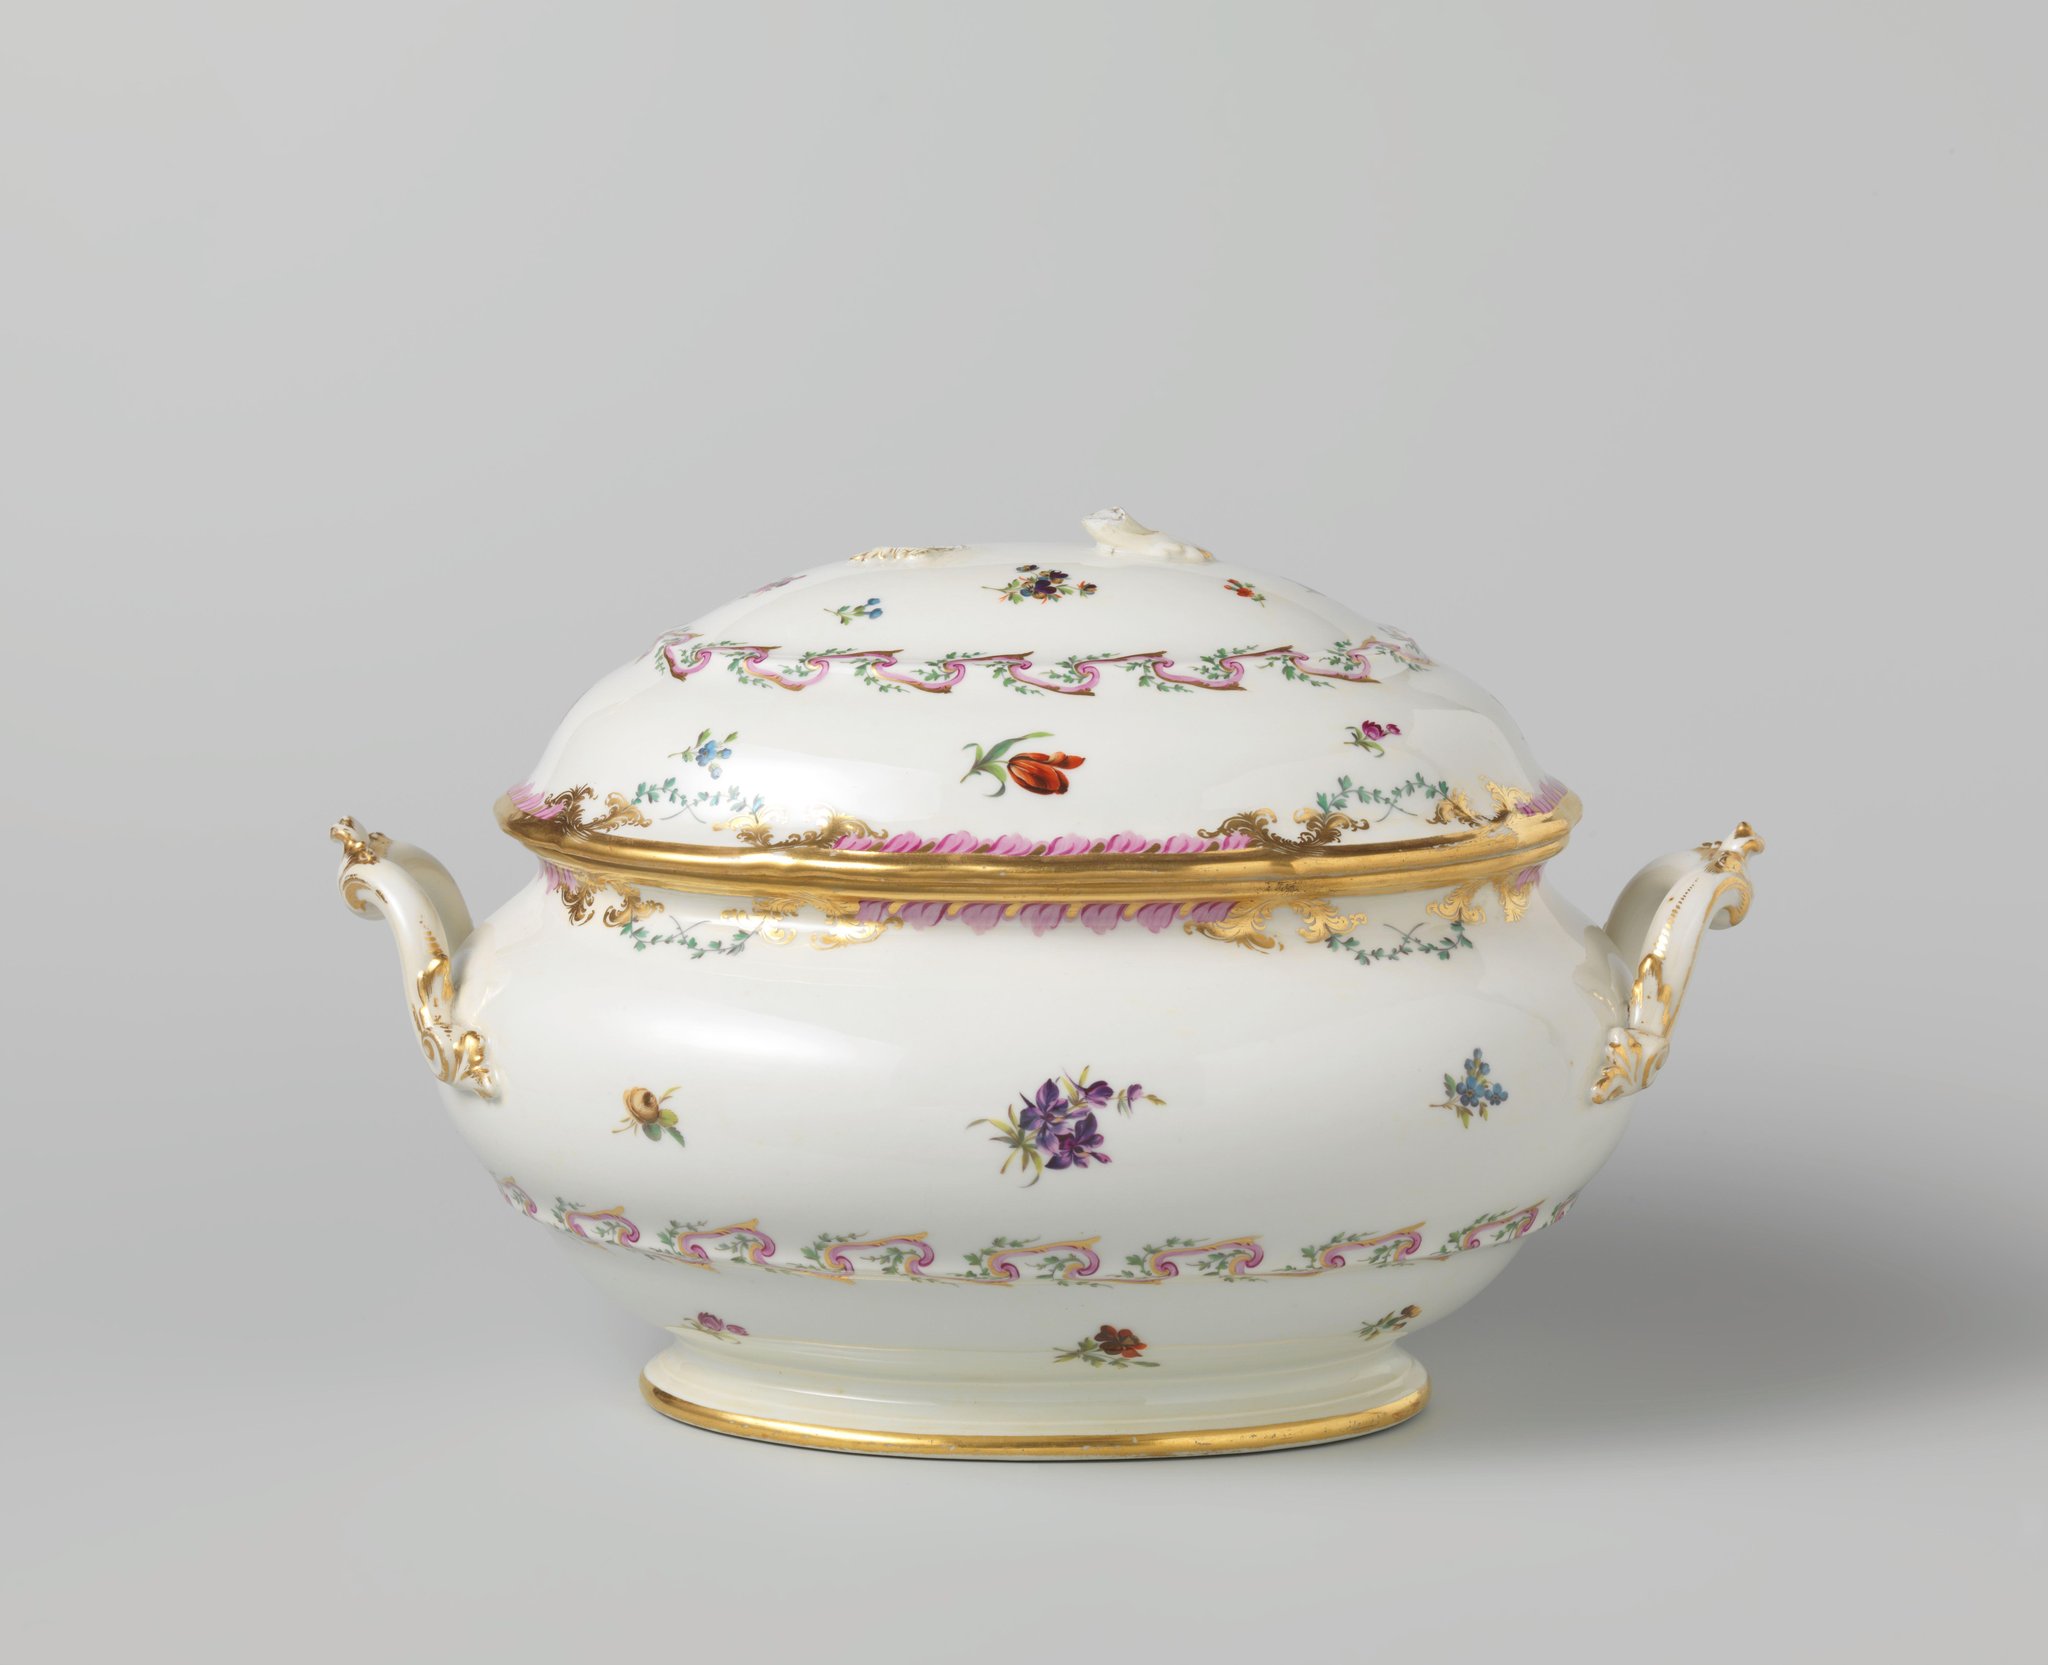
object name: soup tureen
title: Deksel van terrinel, behorend bij een servies met geslingerd lintmotief met bladertakken, bloemboeketten en gestrooide bloemtakken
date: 1780-1820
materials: porcelain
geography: amsterdam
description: Deksel van terrine, behorend bij een servies van porselein, versierd met een geslingerd lintmotief in paars en goud met groene bladertakken, bloemboeketten en gestrooide bloemtakken. Randen lichtgegolfd met decoratie in goud met paars bladmotief waartussen groen gekruist bladmotief. Gemerkt: M.O.L. en Amstel.